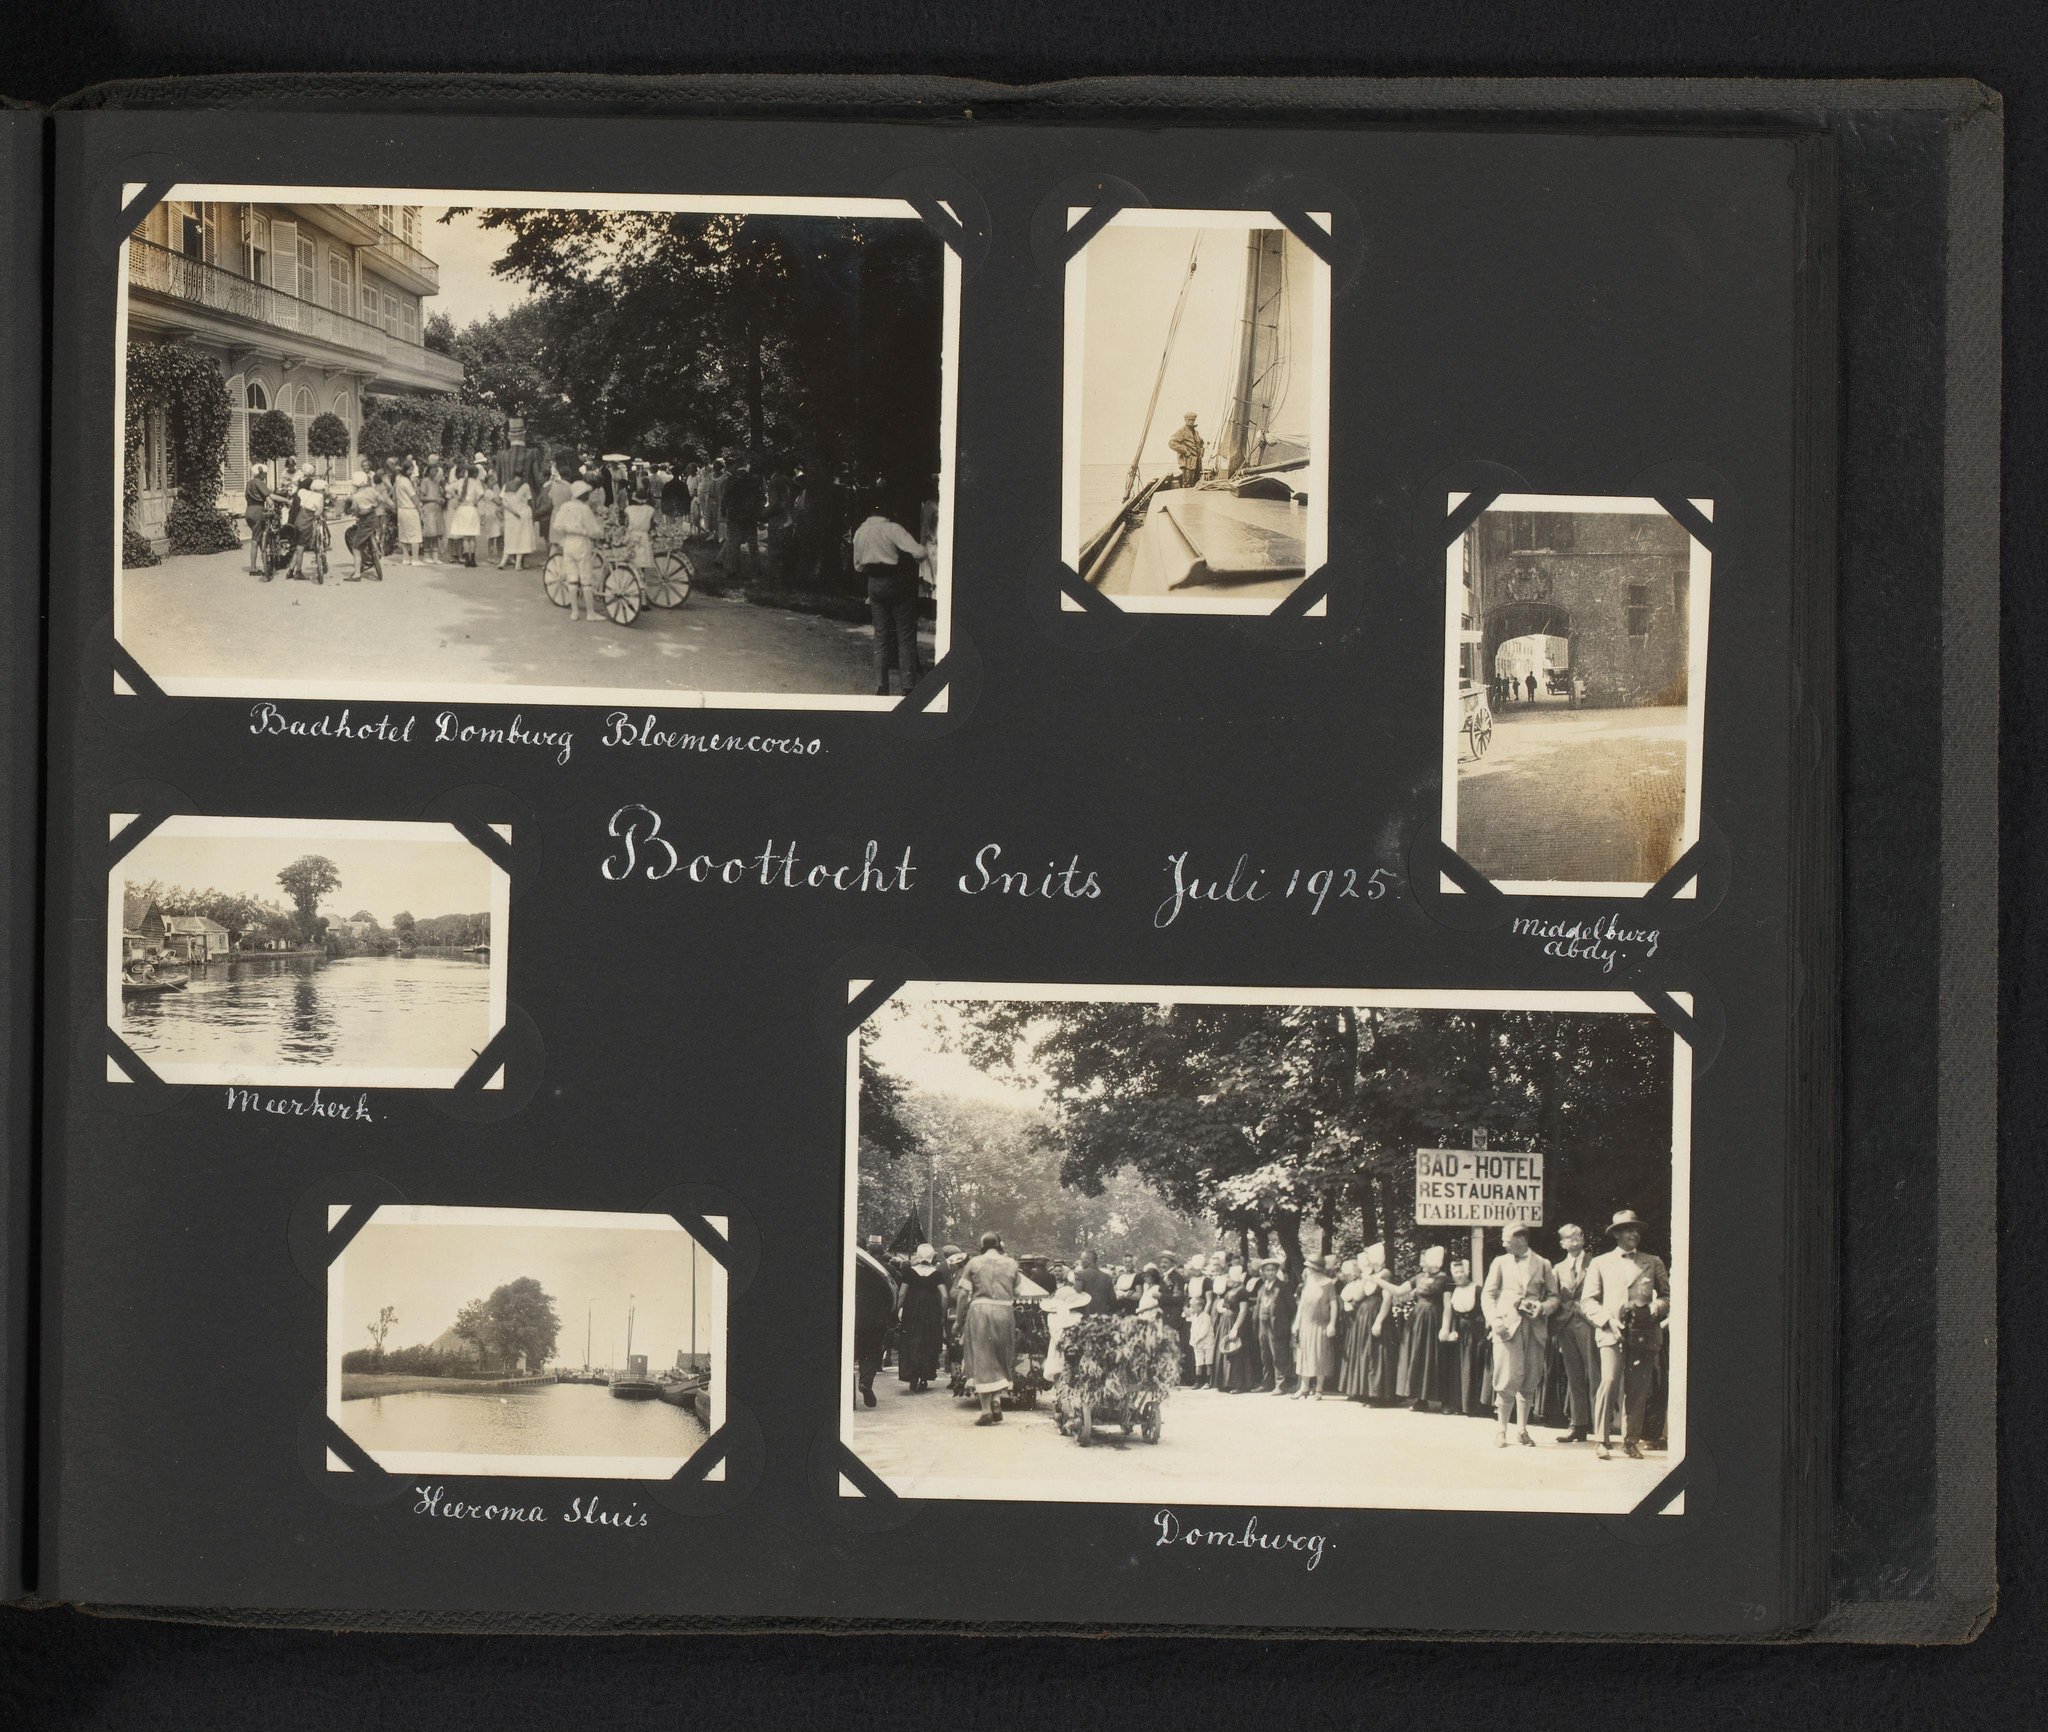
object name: album leaf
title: Zeven foto's van Domburg, Middelburg en Meerkerk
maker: hendrik herman van den berg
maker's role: amateurfotograaf, jurist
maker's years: 1875-1944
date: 1907-1925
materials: paper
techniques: gelatin silver print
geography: netherlands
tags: sailing-ship, sailing-boat, river, middelburg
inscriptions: inscription: ‘Badhotel Domburg Bloemencorso’, inscription: ‘Meerkerk’, inscription: ‘Middelburg/ Abdij.’, inscription: ‘Heeroma Sluis’, inscription: ‘Domburg’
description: Deze foto's maken deel uit van een album.